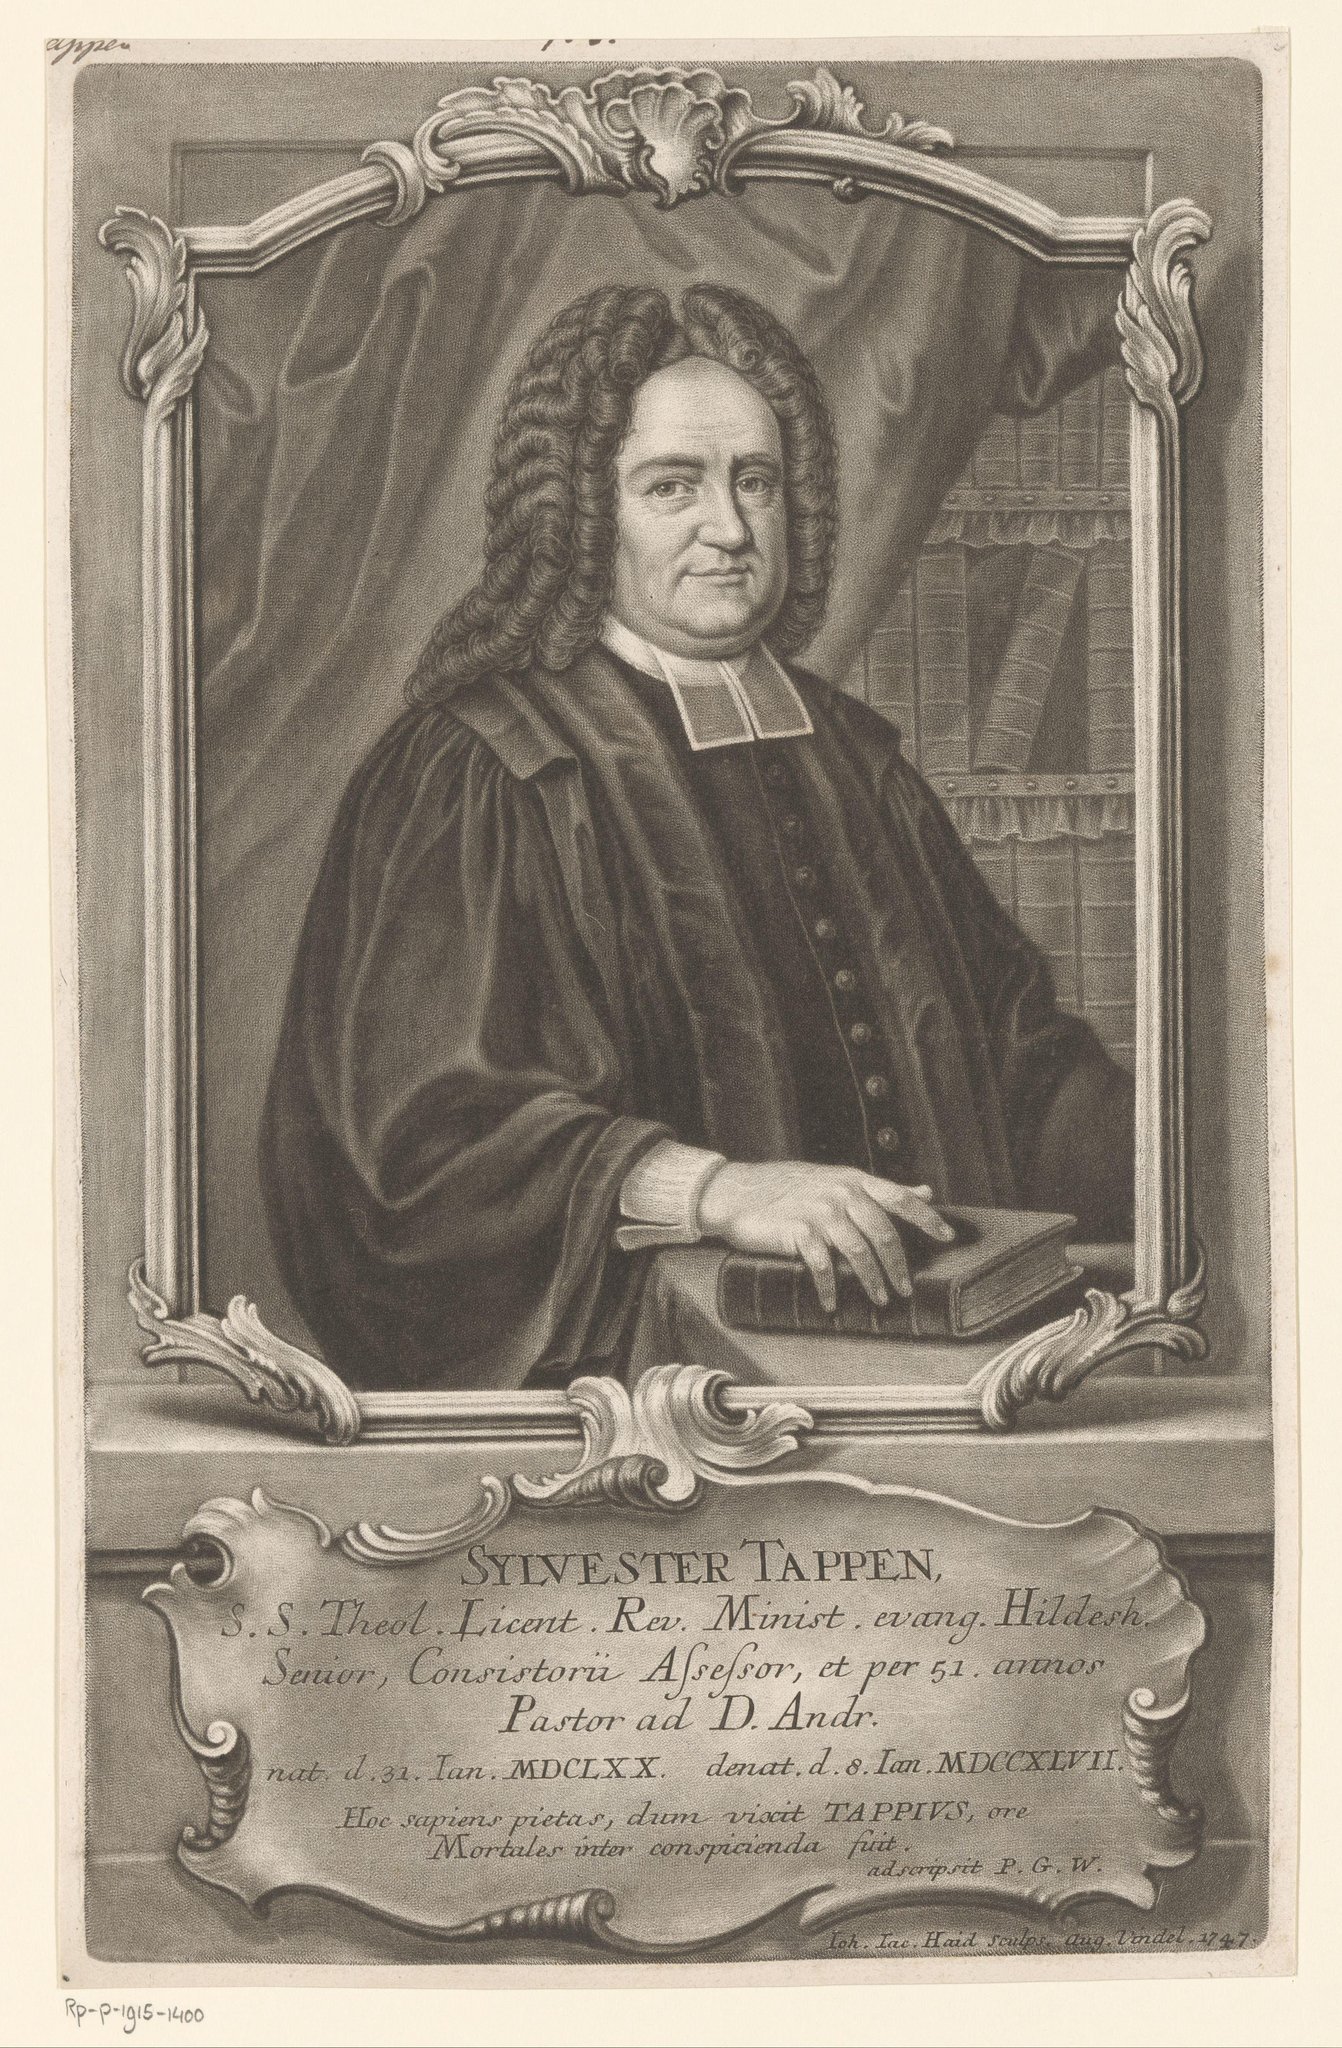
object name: print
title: Portret van Wilhelm Gottlieb Tafinger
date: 1757-1767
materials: paper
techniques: etching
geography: augsburg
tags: bookshelves, historical persons, armorial bearing, heraldry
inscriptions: collector's mark: Lugt 2228